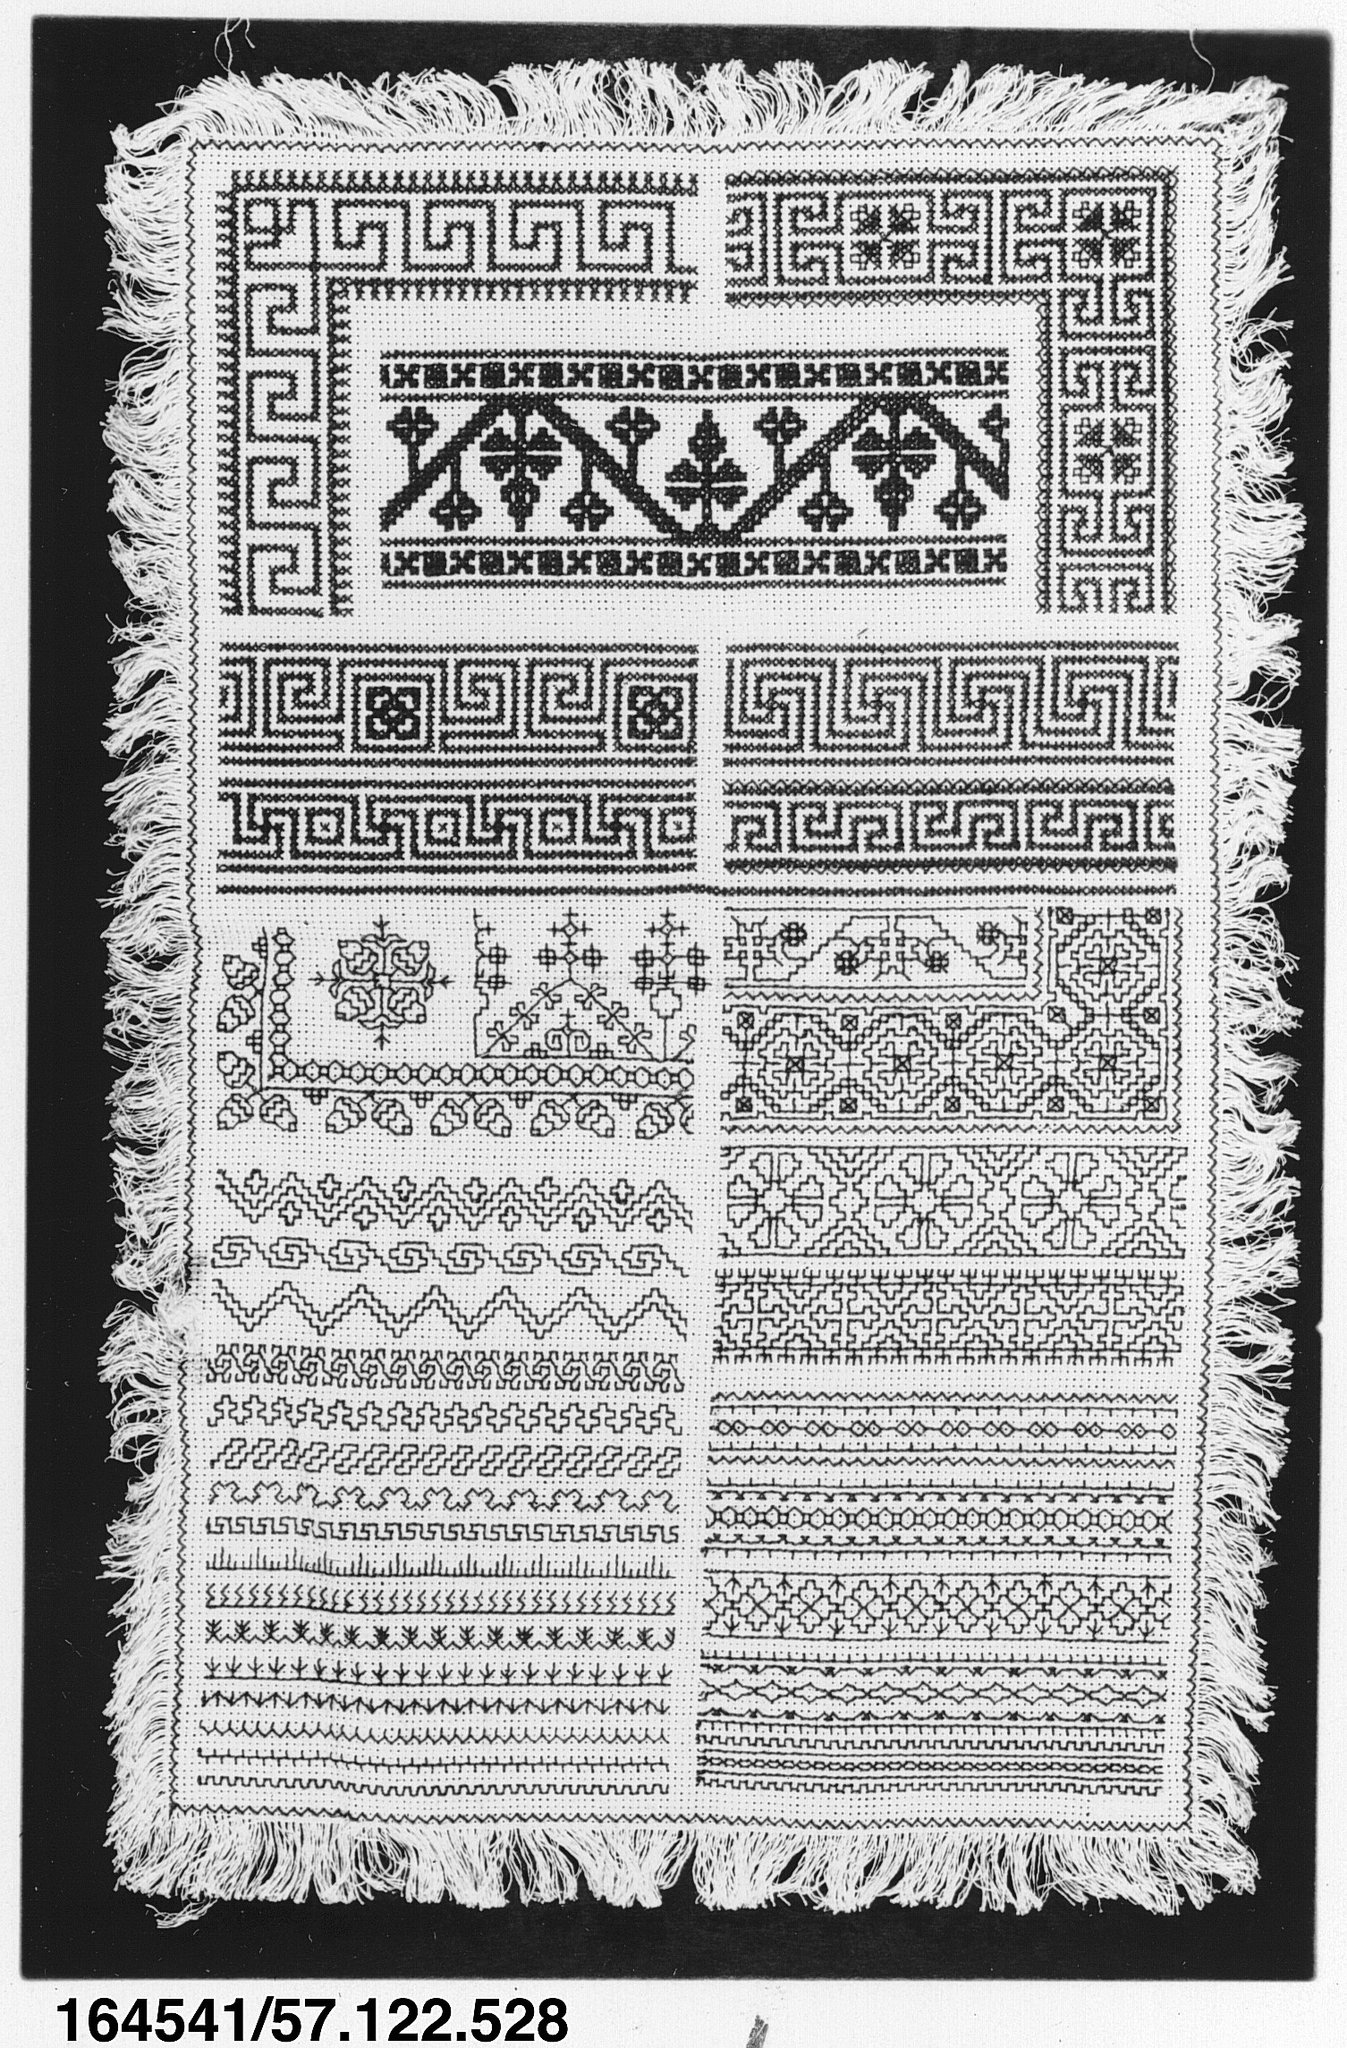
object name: sampler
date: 1801-1900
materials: cotton